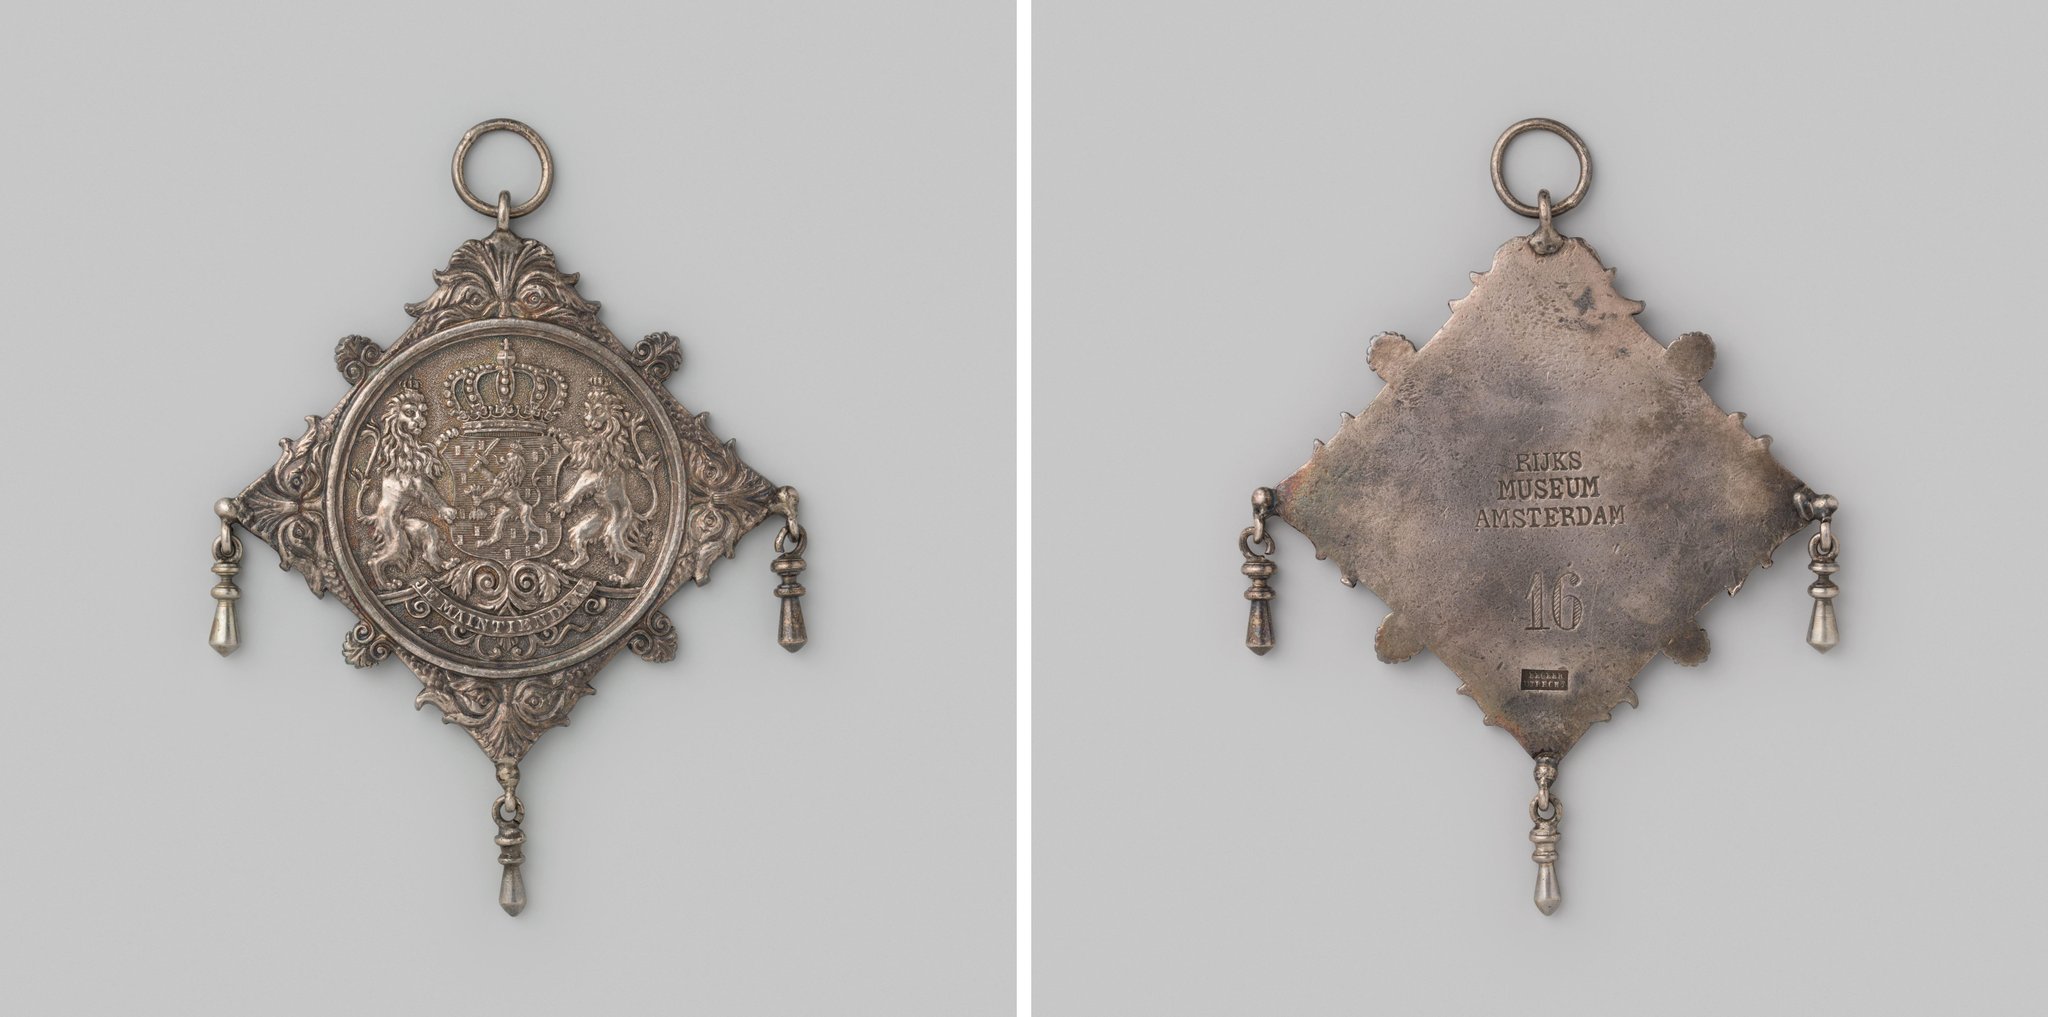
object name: insignia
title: Insigne voor zaalwachters, nr. 16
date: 1889-1890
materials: silver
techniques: striking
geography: utrecht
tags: rijksmuseum amsterdam, amsterdam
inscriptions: inscription: ‘RIJKSMUSEUM AMSTERDAM 16’, inscription: ‘JE MAINTIENDRAI’, mark: ‘BEGEER UTRECHT’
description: Zilveren, ruitvormige insigne voor de zaalwachter van het Rijksmuseum Amsterdam aan een draagring. Drie hoeken voorzien van een hangertje. Voorzijde: het wapen van Nederland (gekroond wapenschild geflankeerd door twee klimmende leeuwen) waaronder opschrift. Keerzijde: opschrift en nummer.